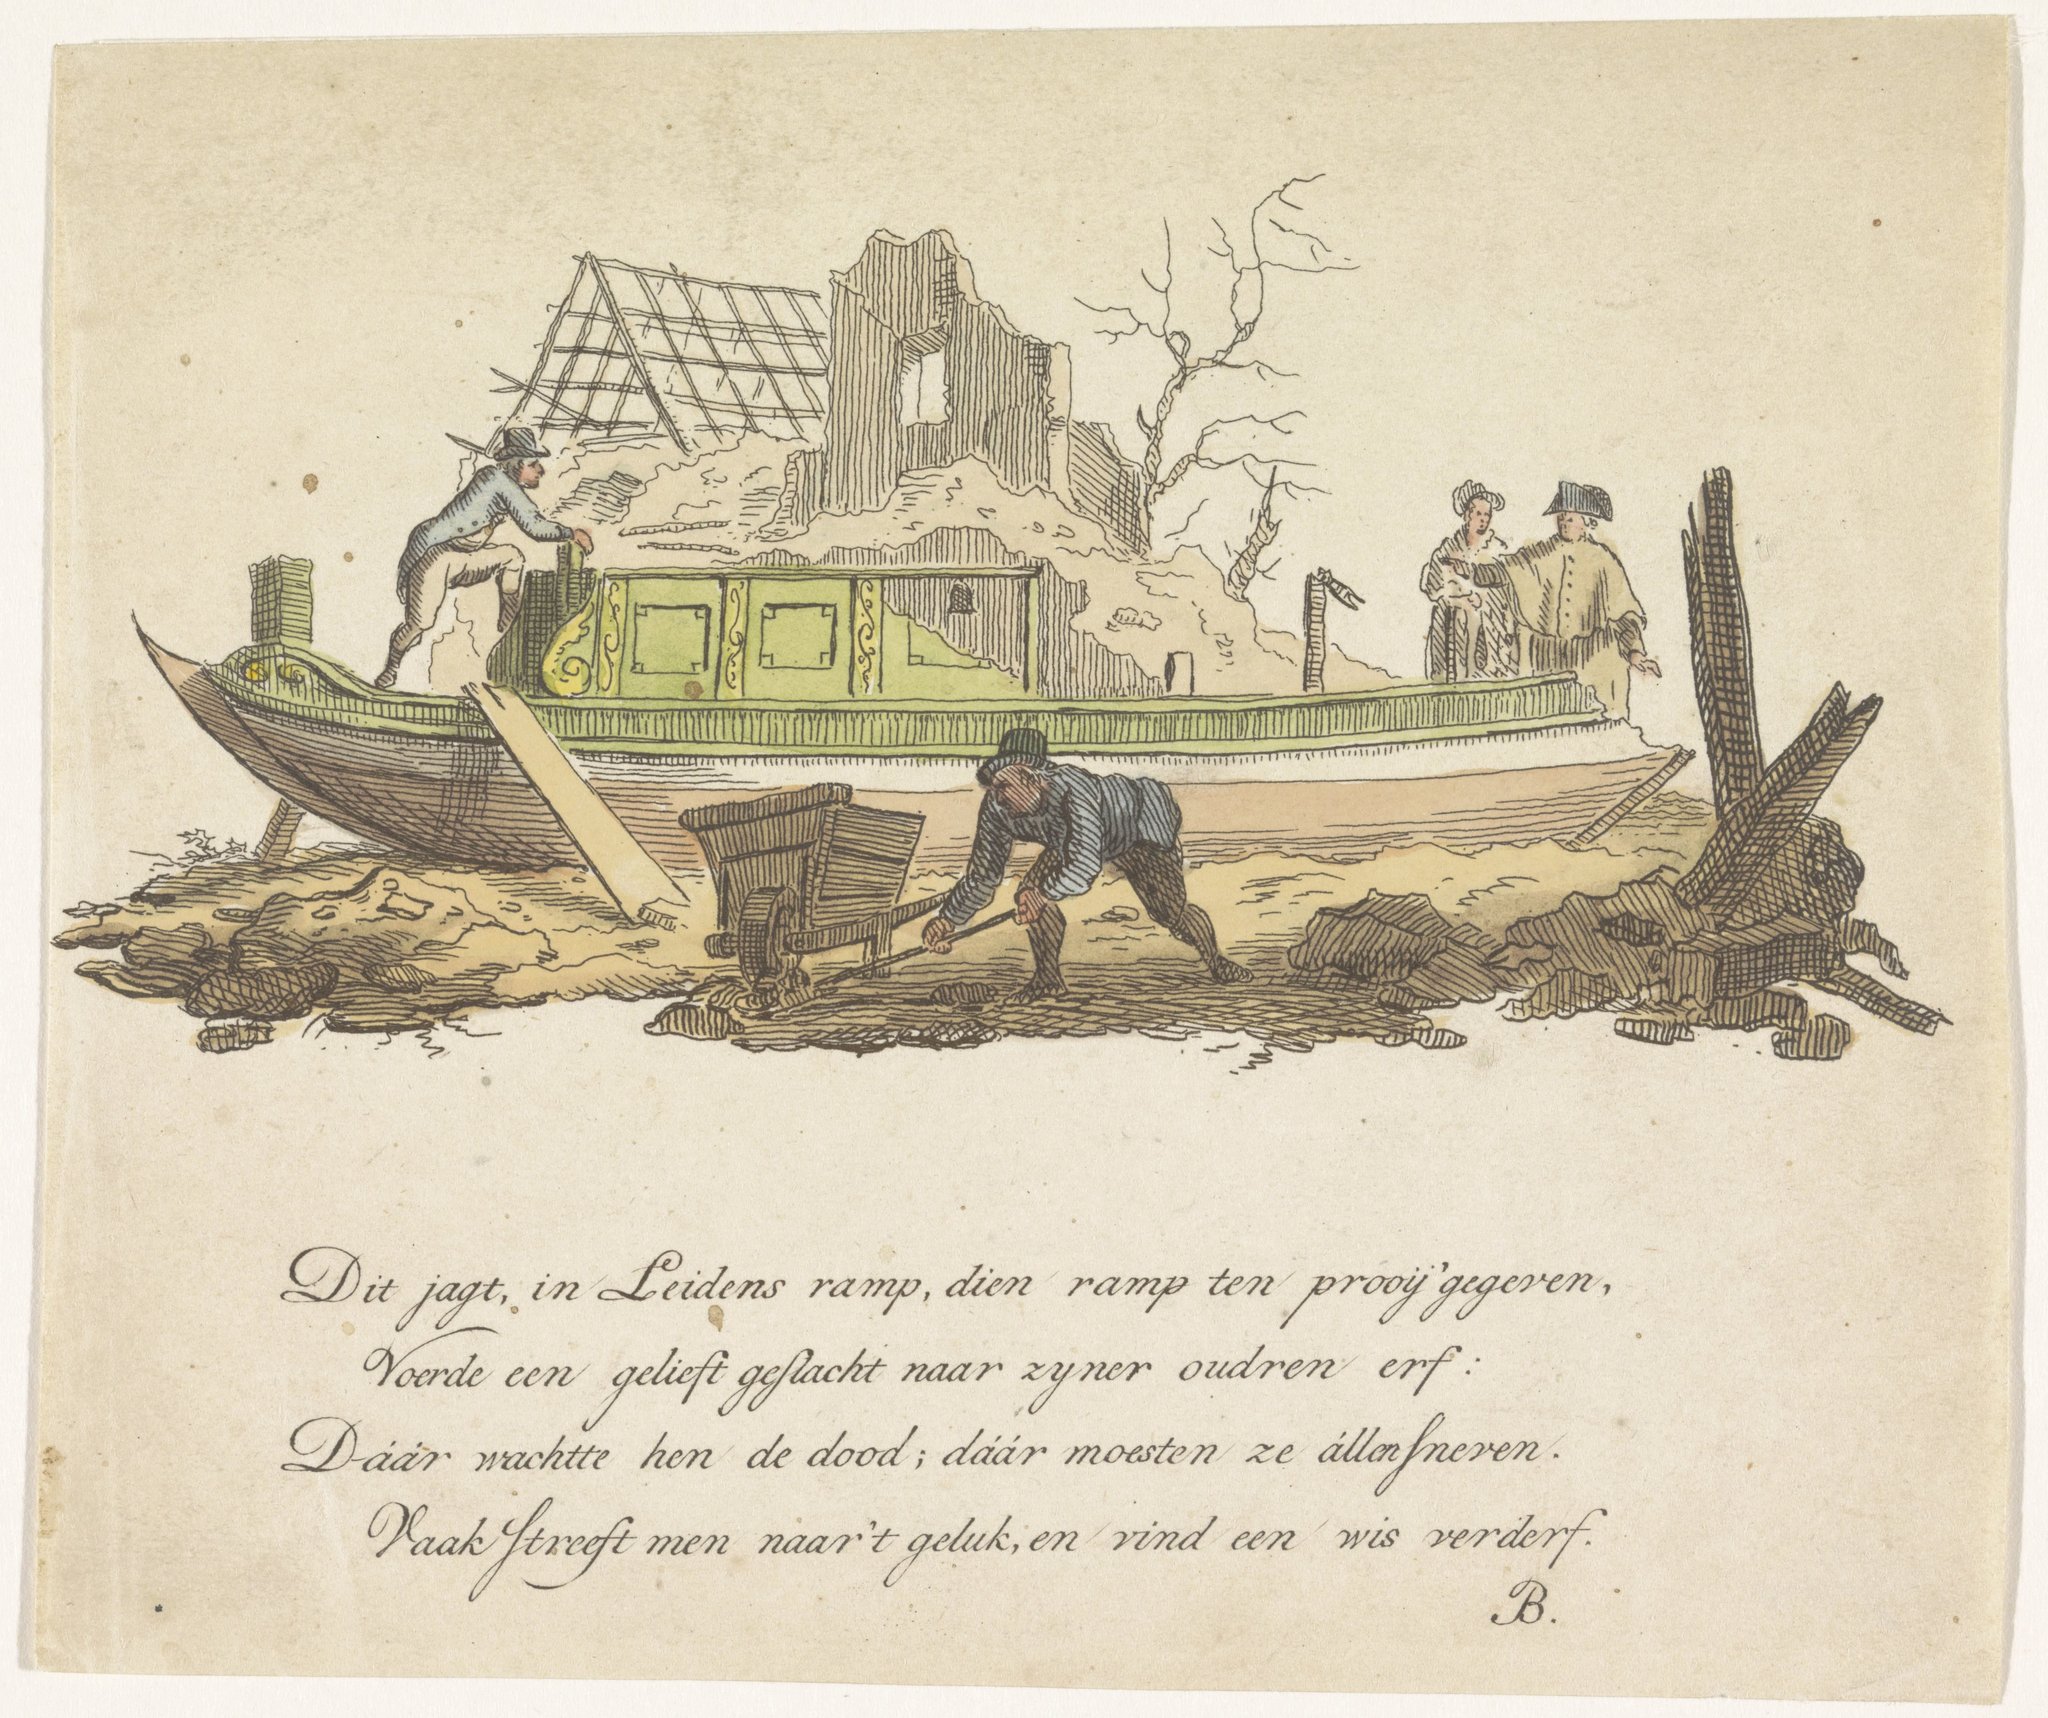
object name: print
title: Verbrijzelde jacht van Rietmilder, 1807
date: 1807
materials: paper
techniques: etching, hand coloring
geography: netherlands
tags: leiden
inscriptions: collector's mark: Lugt 2228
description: Het verbrijzelde jacht van de heer Pieter Rietmilder dat op het moment van de buskruitramp in Leiden op 12 januari 1807 schuin tegenover het kruitschip in het water aan het Steenschuur lag. Met enkele toeschouwers, op de voorgrond een arbeider met een kruiwagen. Onderaan een vierregelig vers.